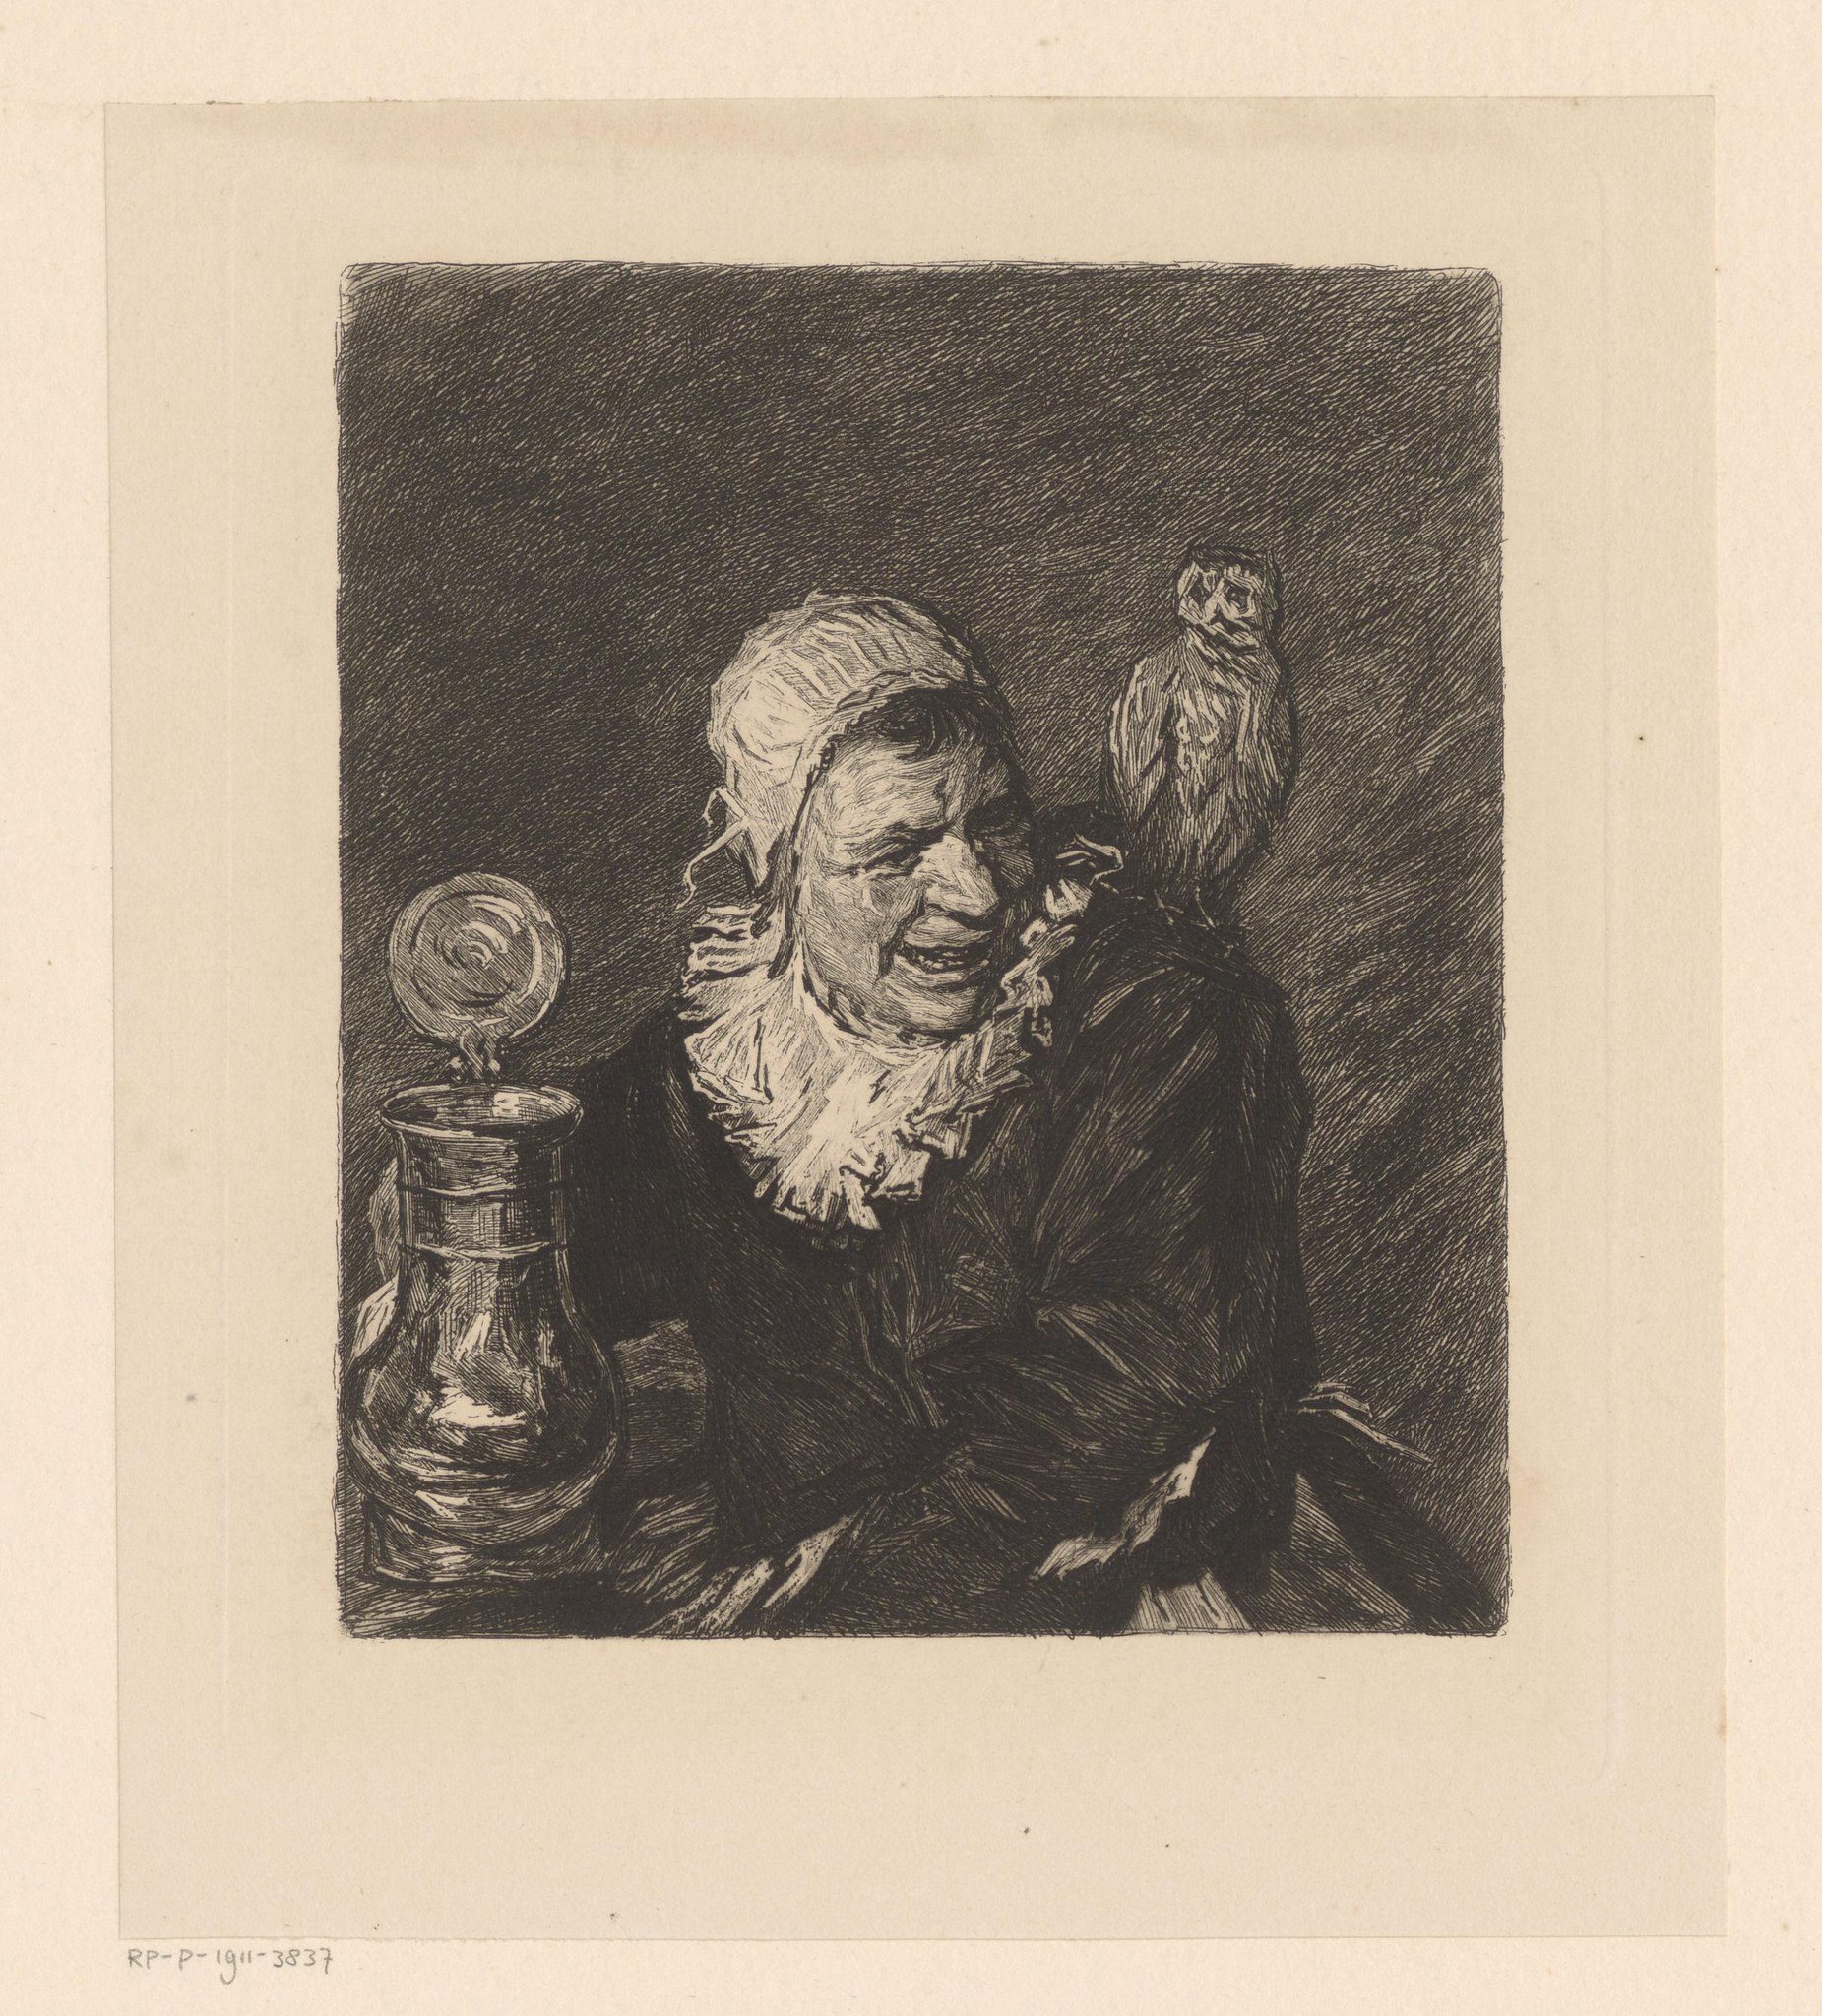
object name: print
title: Portret van Barbara Claes met een uil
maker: william unger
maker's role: draughtsman, painter, print maker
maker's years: 1837-1932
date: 1847-1889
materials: paper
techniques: etching, intaglio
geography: germany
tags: historical persons - bb - woman, jar, jug (used as drinking-vessel), owls, drinking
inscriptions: collector's mark: Lugt 2228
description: Prent naar het schilderij door Frans Hals in de Gemäldegalerie te Berlin (inv.nr. 801C).